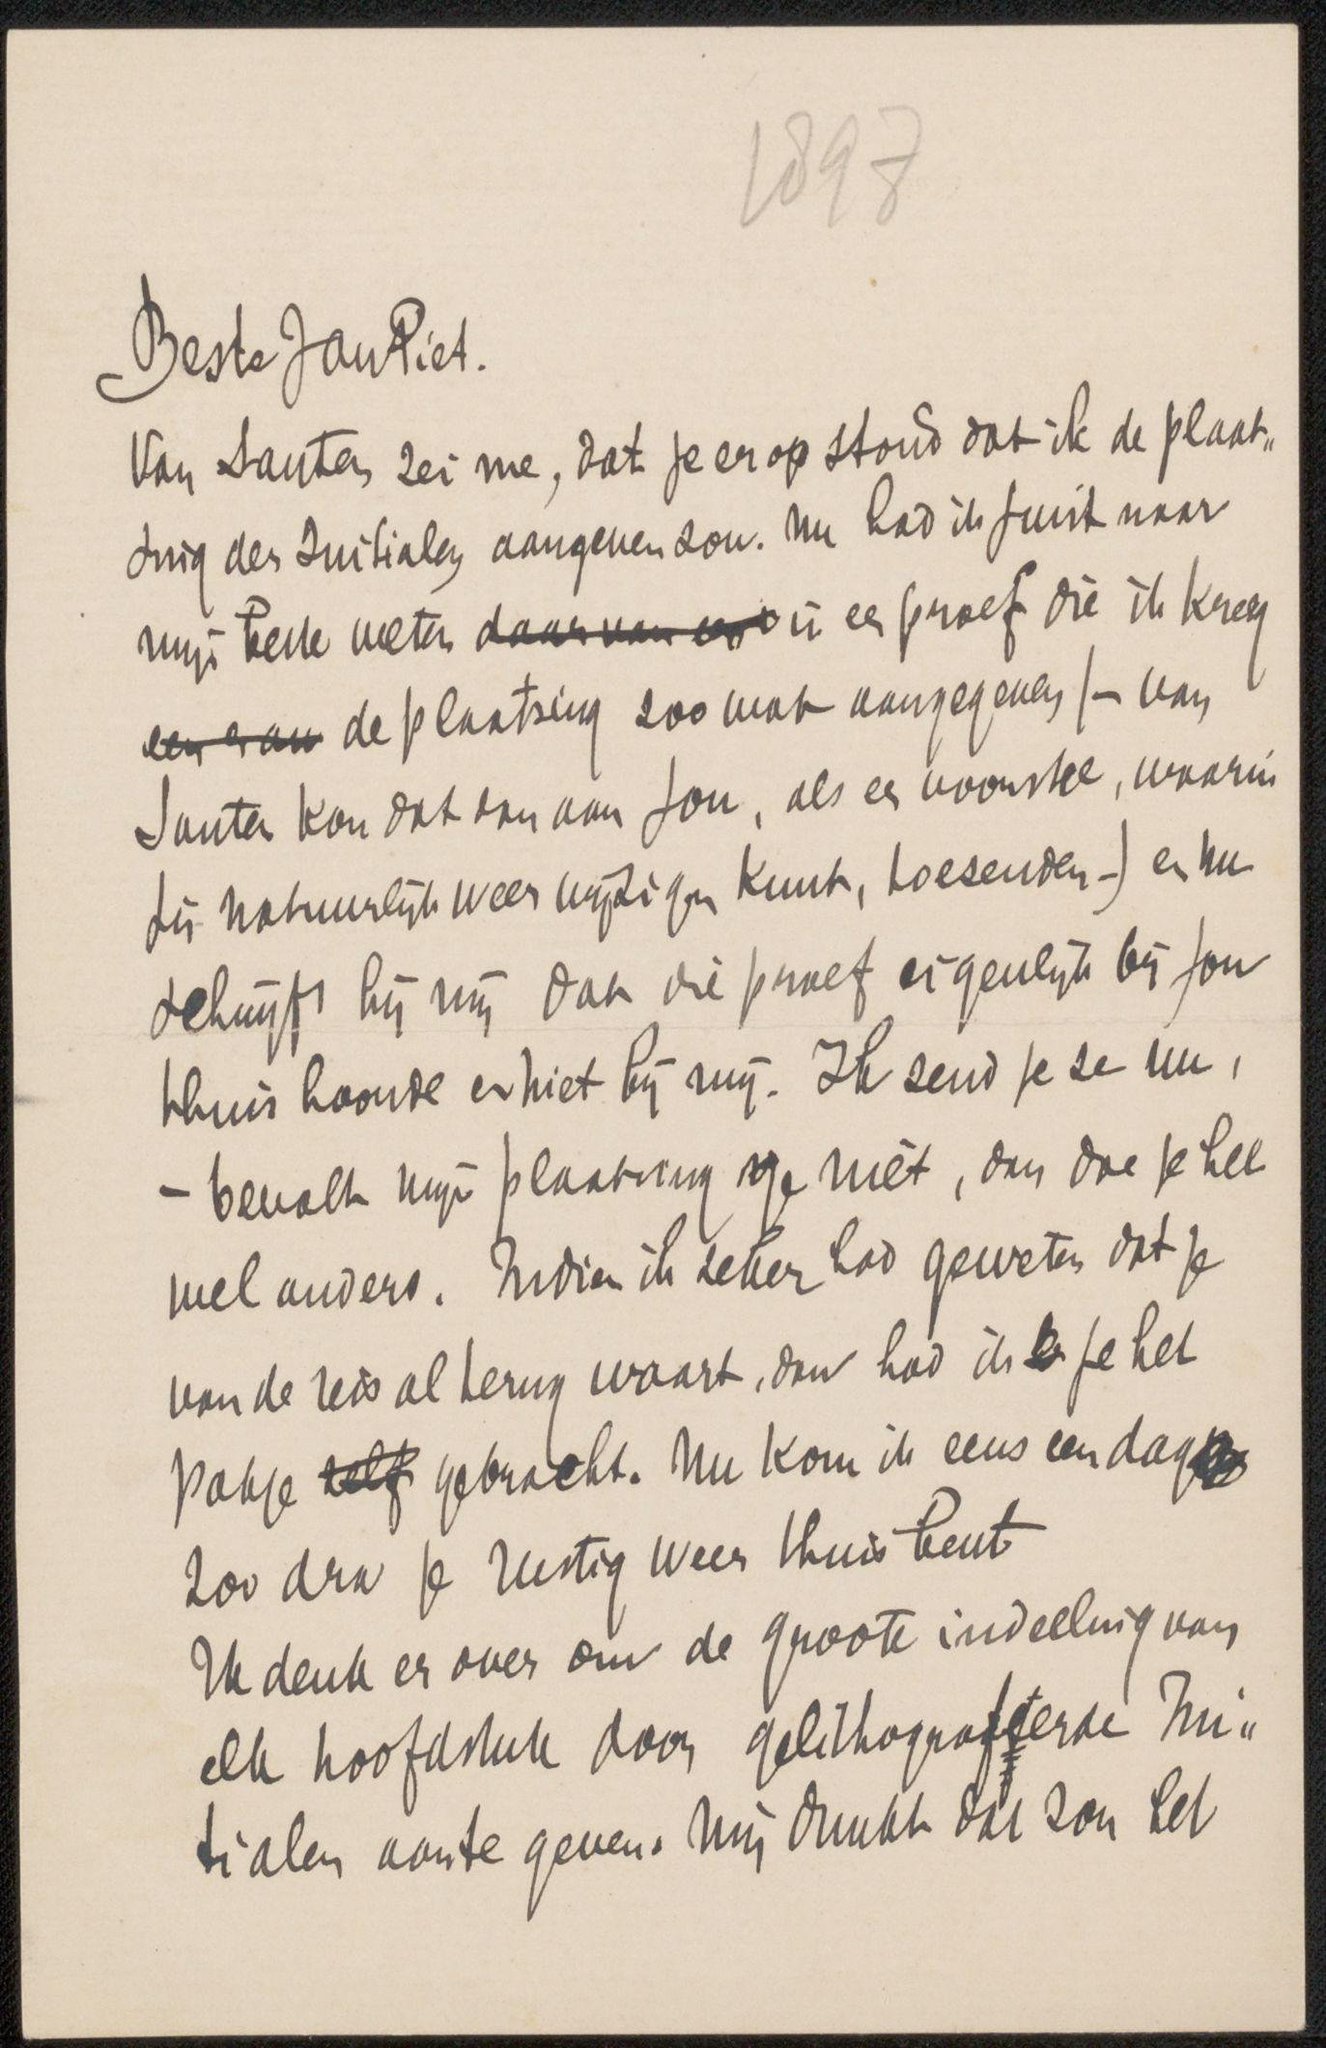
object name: letter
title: Brief aan Jan Veth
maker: antoon derkinderen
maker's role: draughtsman, painter, print maker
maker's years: 1859-1925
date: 1874-1925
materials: ink, paper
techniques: pen, writing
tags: painter, print maker, draughtsman, designer, jan veth, the graphic arts, printed matter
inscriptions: collector's mark: ‘RPK’